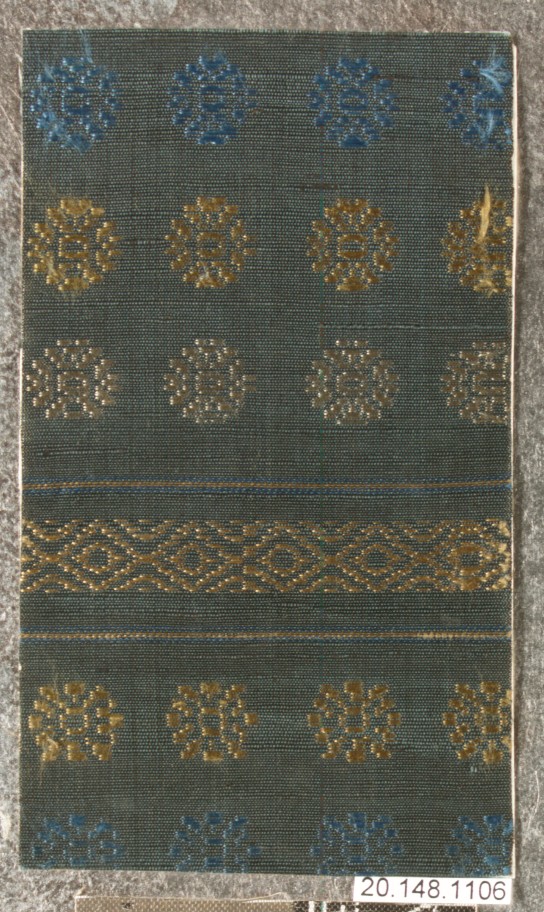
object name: piece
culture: japanese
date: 1701-1800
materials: silk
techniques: compound weave